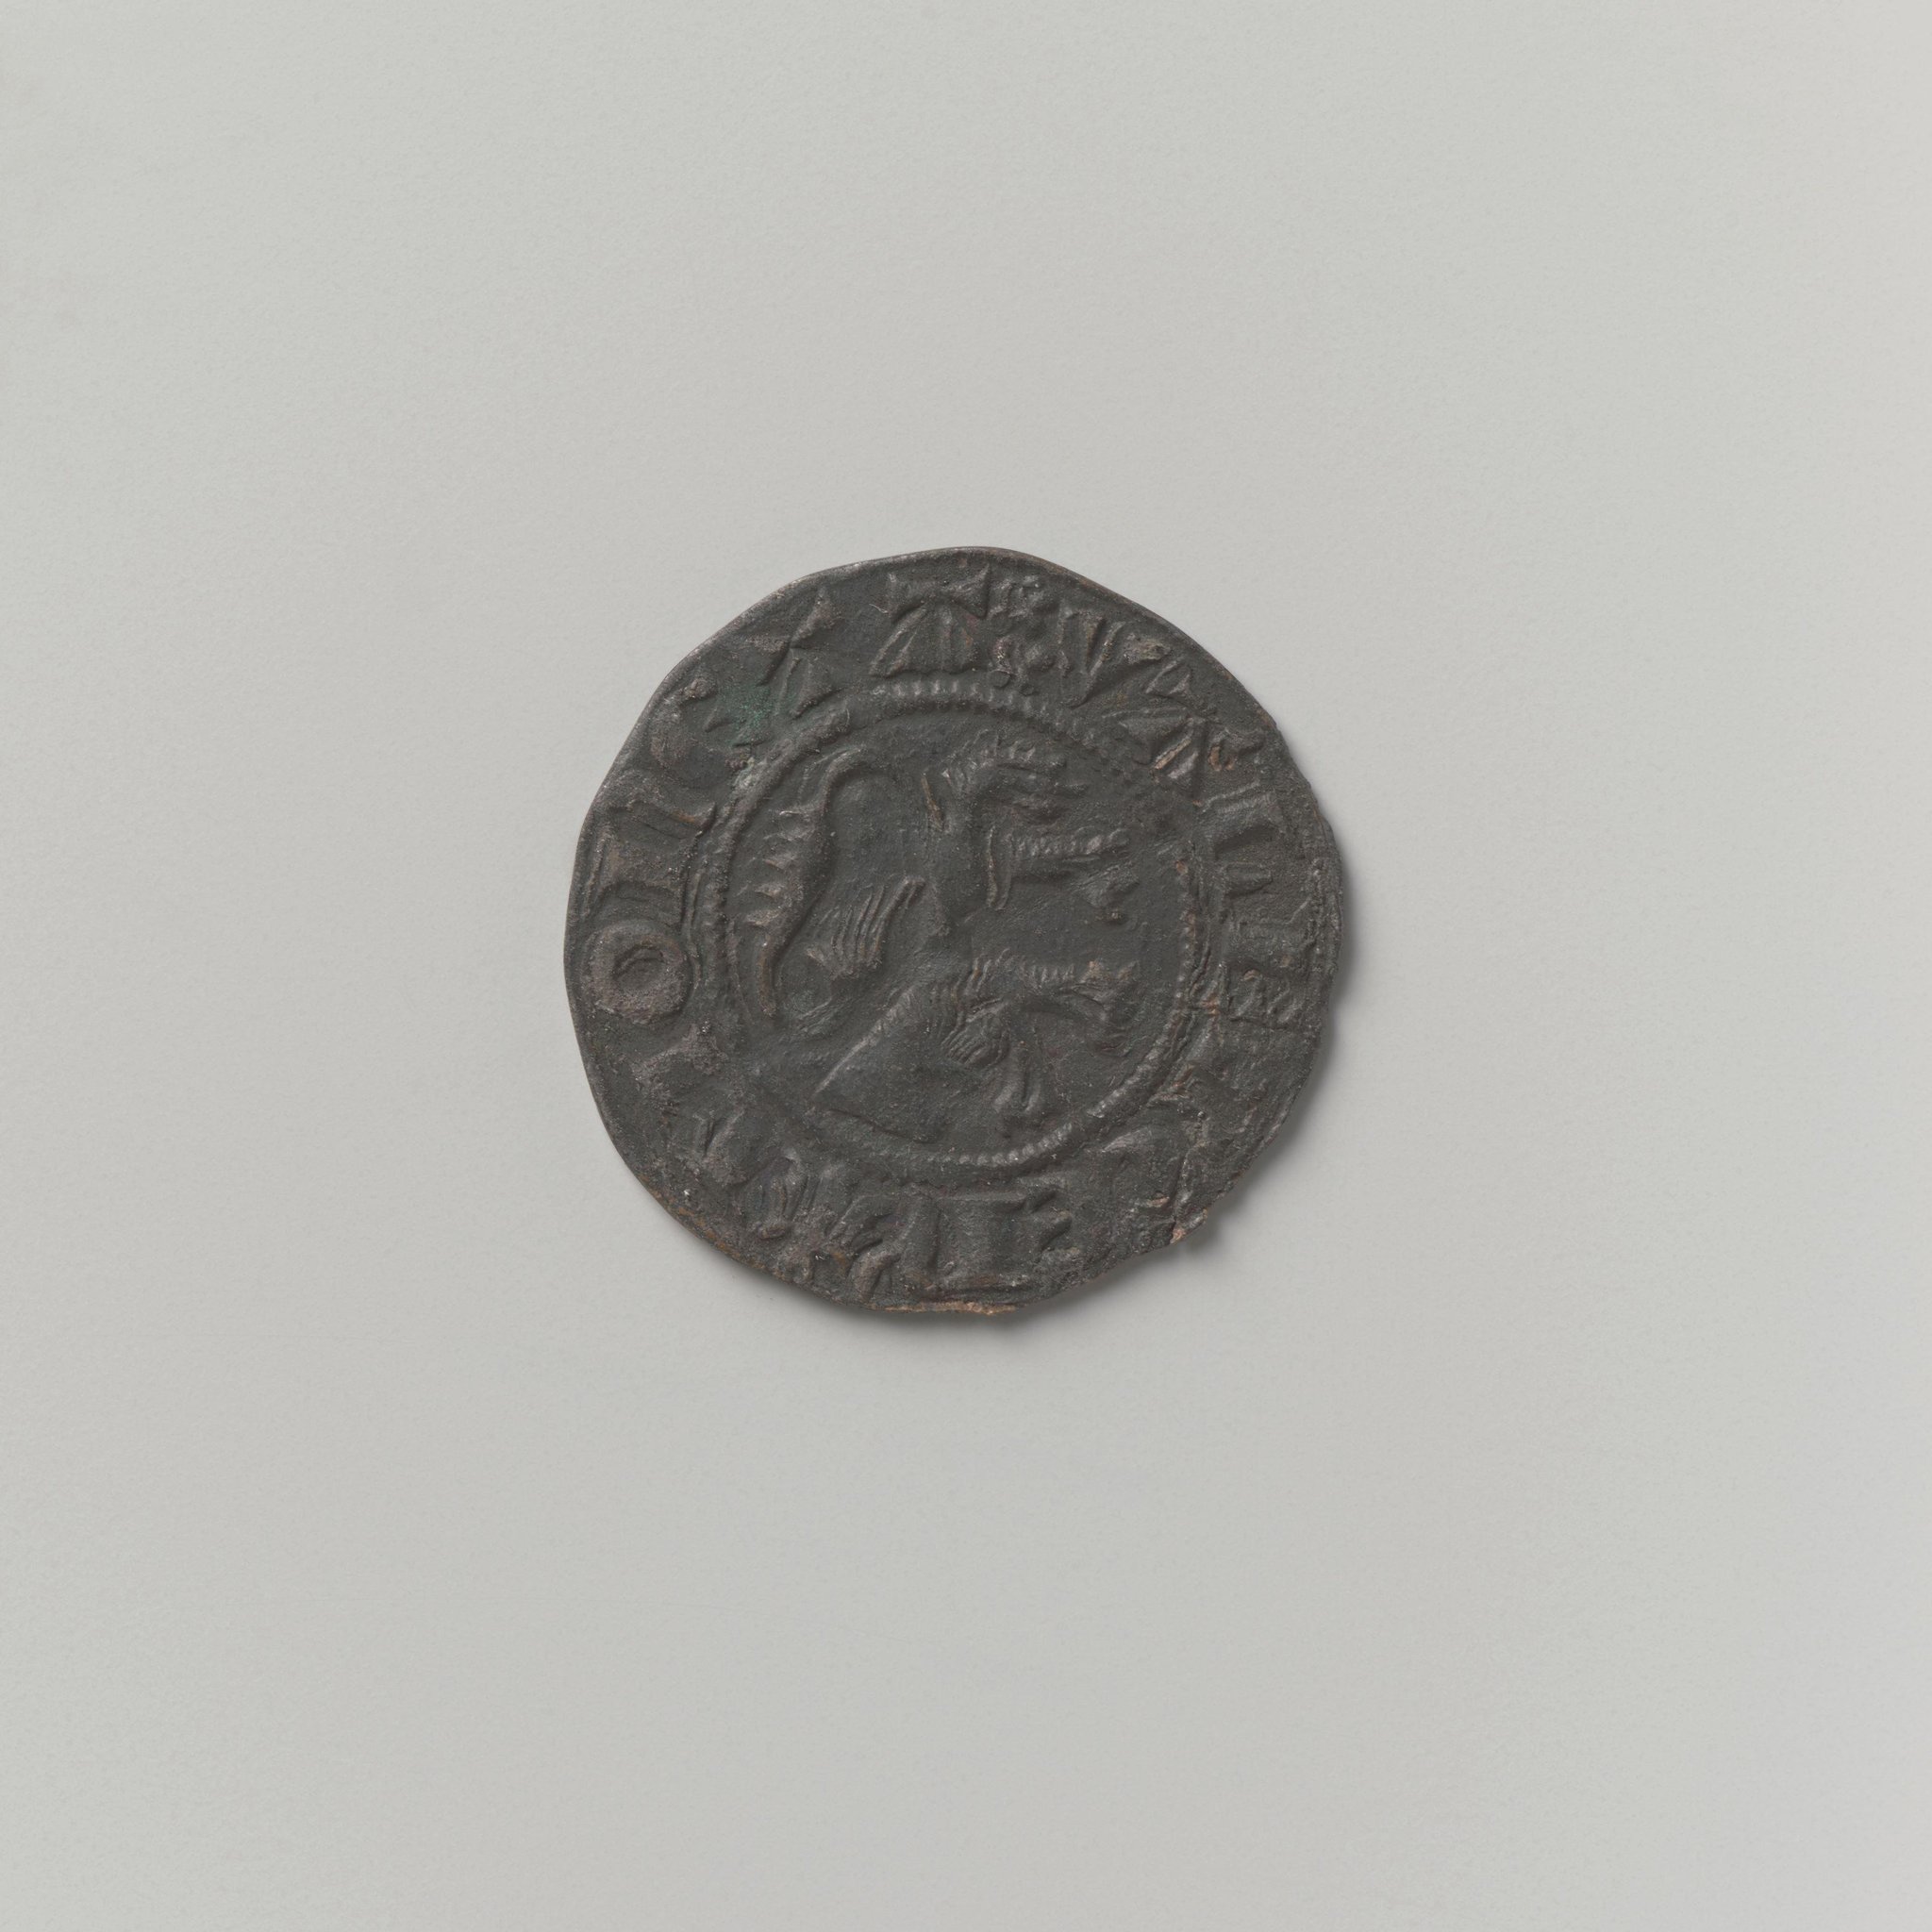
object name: coin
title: 1/3 groot uit Henegouwen van Willem II, 1337-1345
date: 1337-1345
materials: silver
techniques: striking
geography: valenciennes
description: Zilveren munt. Voorzijde: klimmende leeuw naar links. Keerzijde: lang gevoet kruis, in de hoeken bladversiering. Omschrift: ECO-MES-HAN-ONI. Eigentijdse vervalsing?